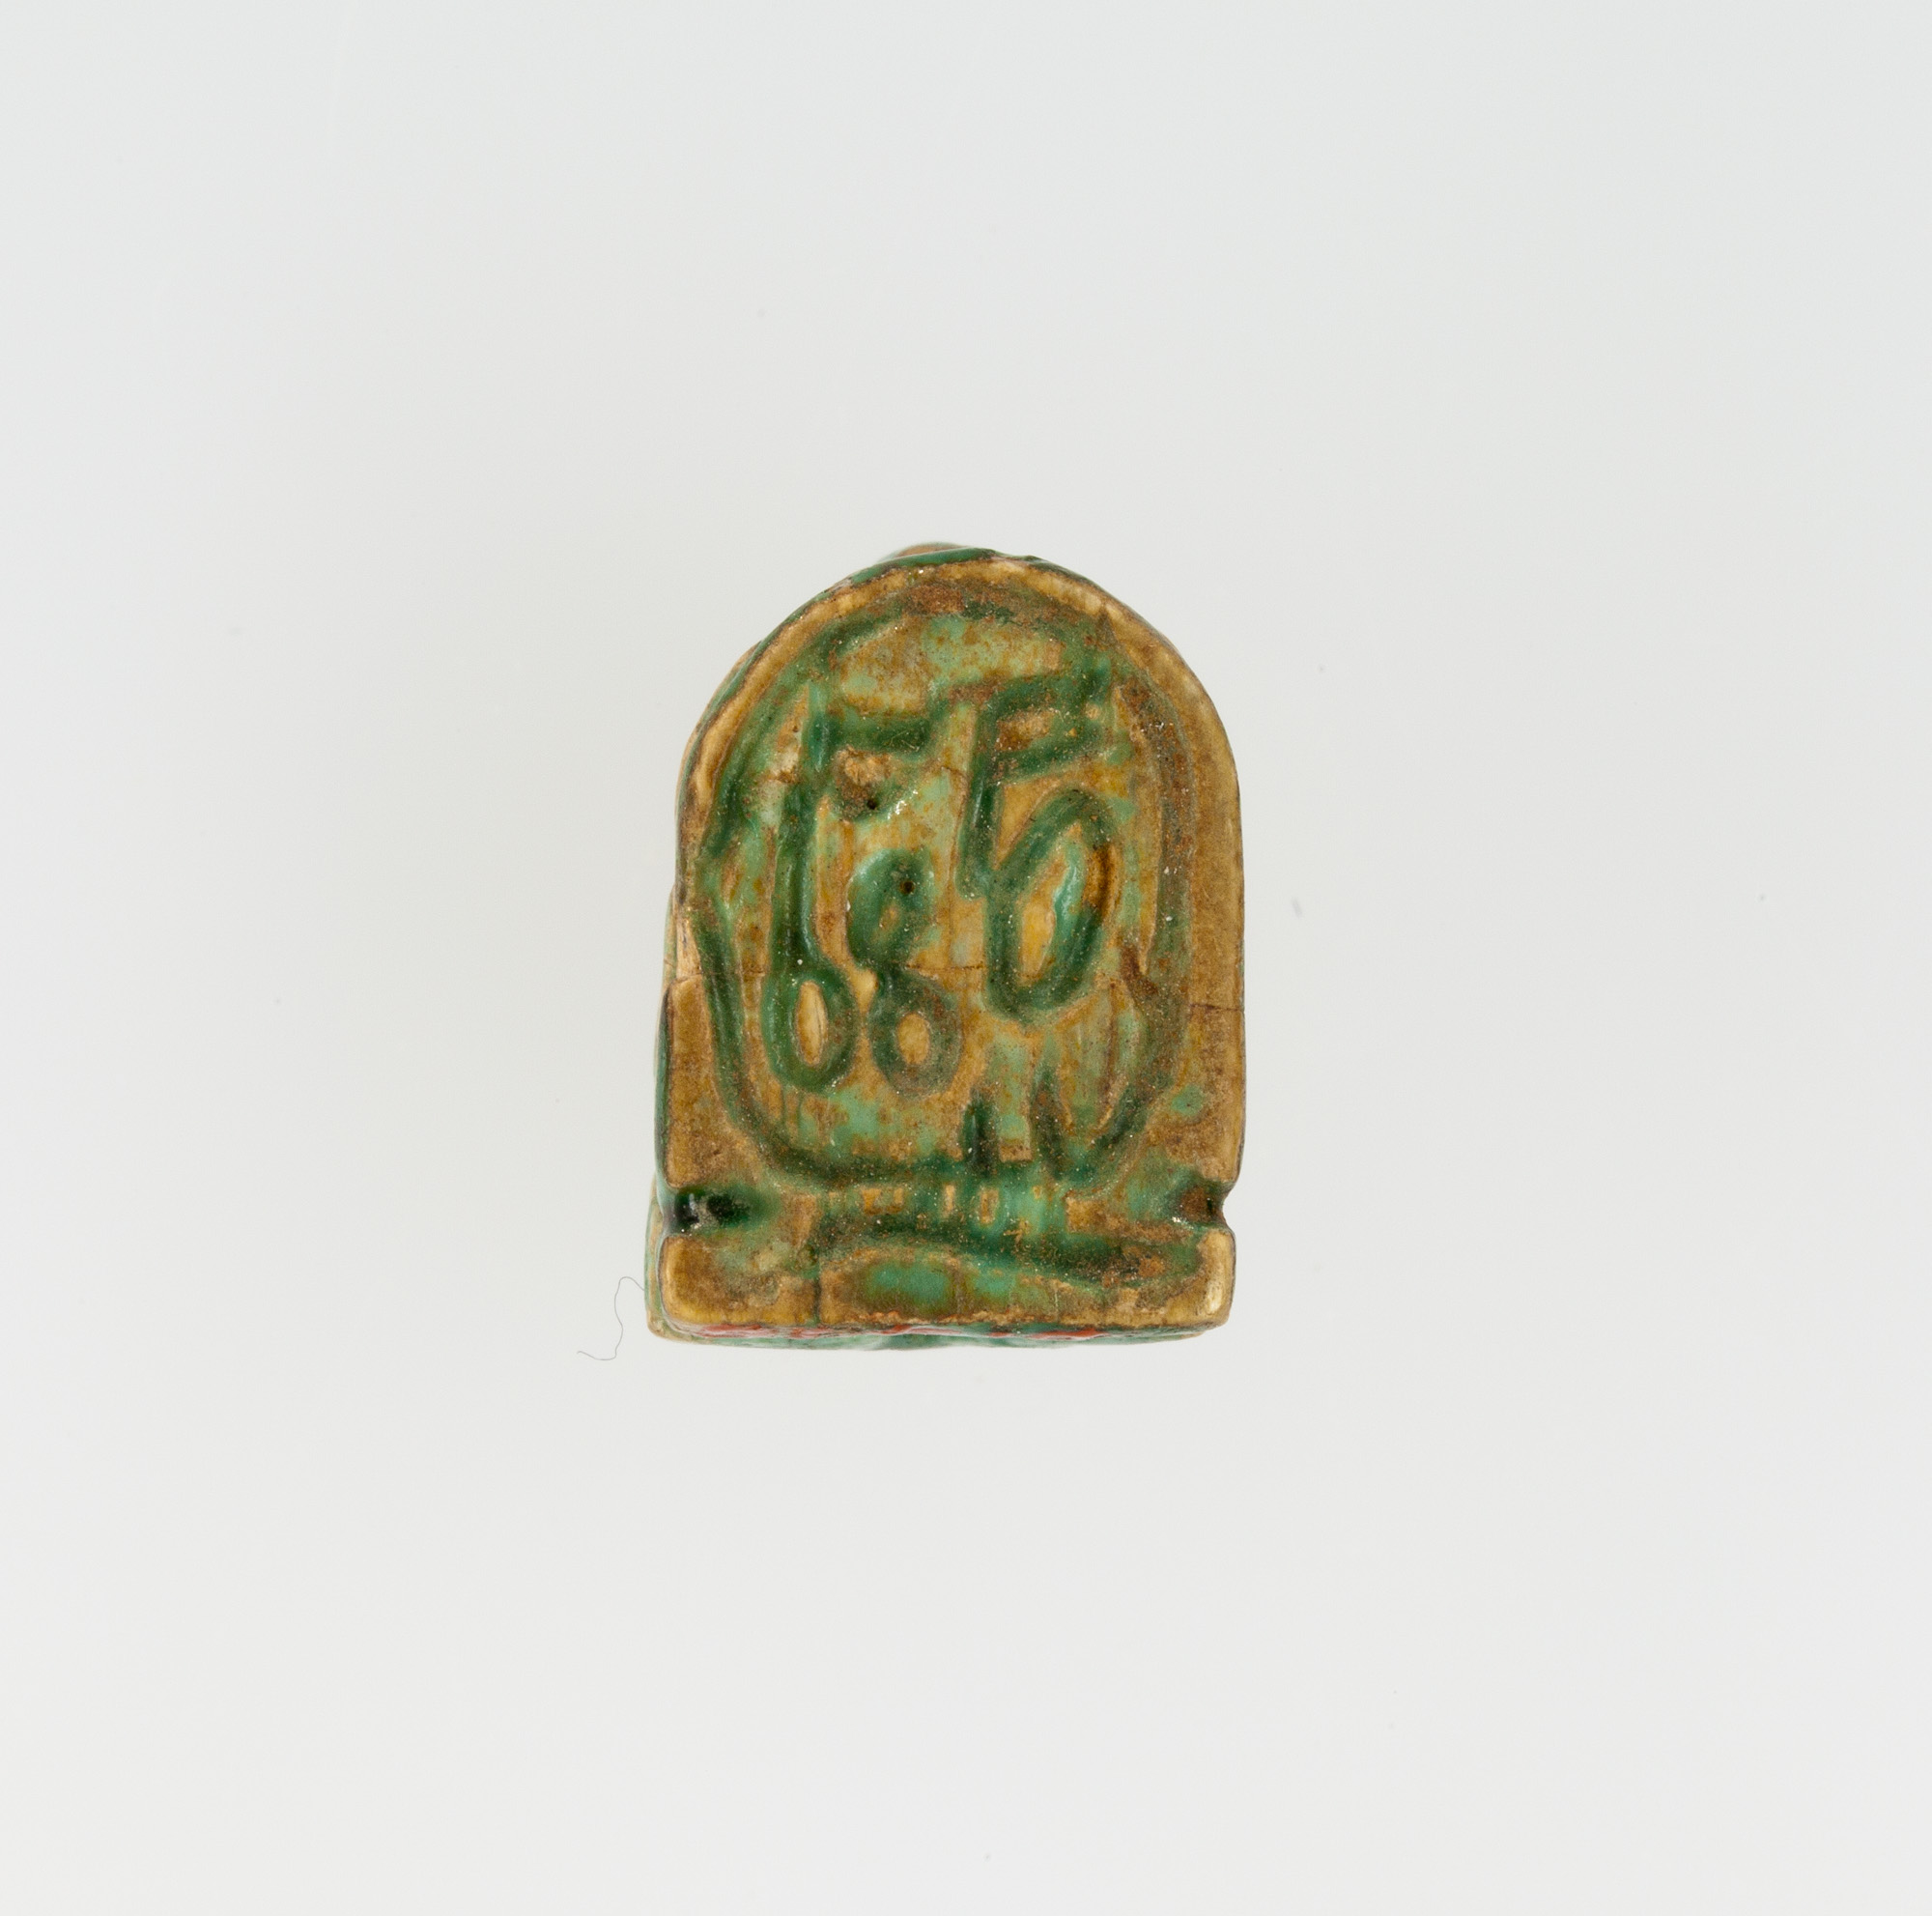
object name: duck seal amulet, ahmose nefertari, god's wife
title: Duck-Shaped Stamp Seal Inscribed for (Ahmose-)Nefertari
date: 1550-1525 BCE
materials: stone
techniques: glazing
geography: egypt